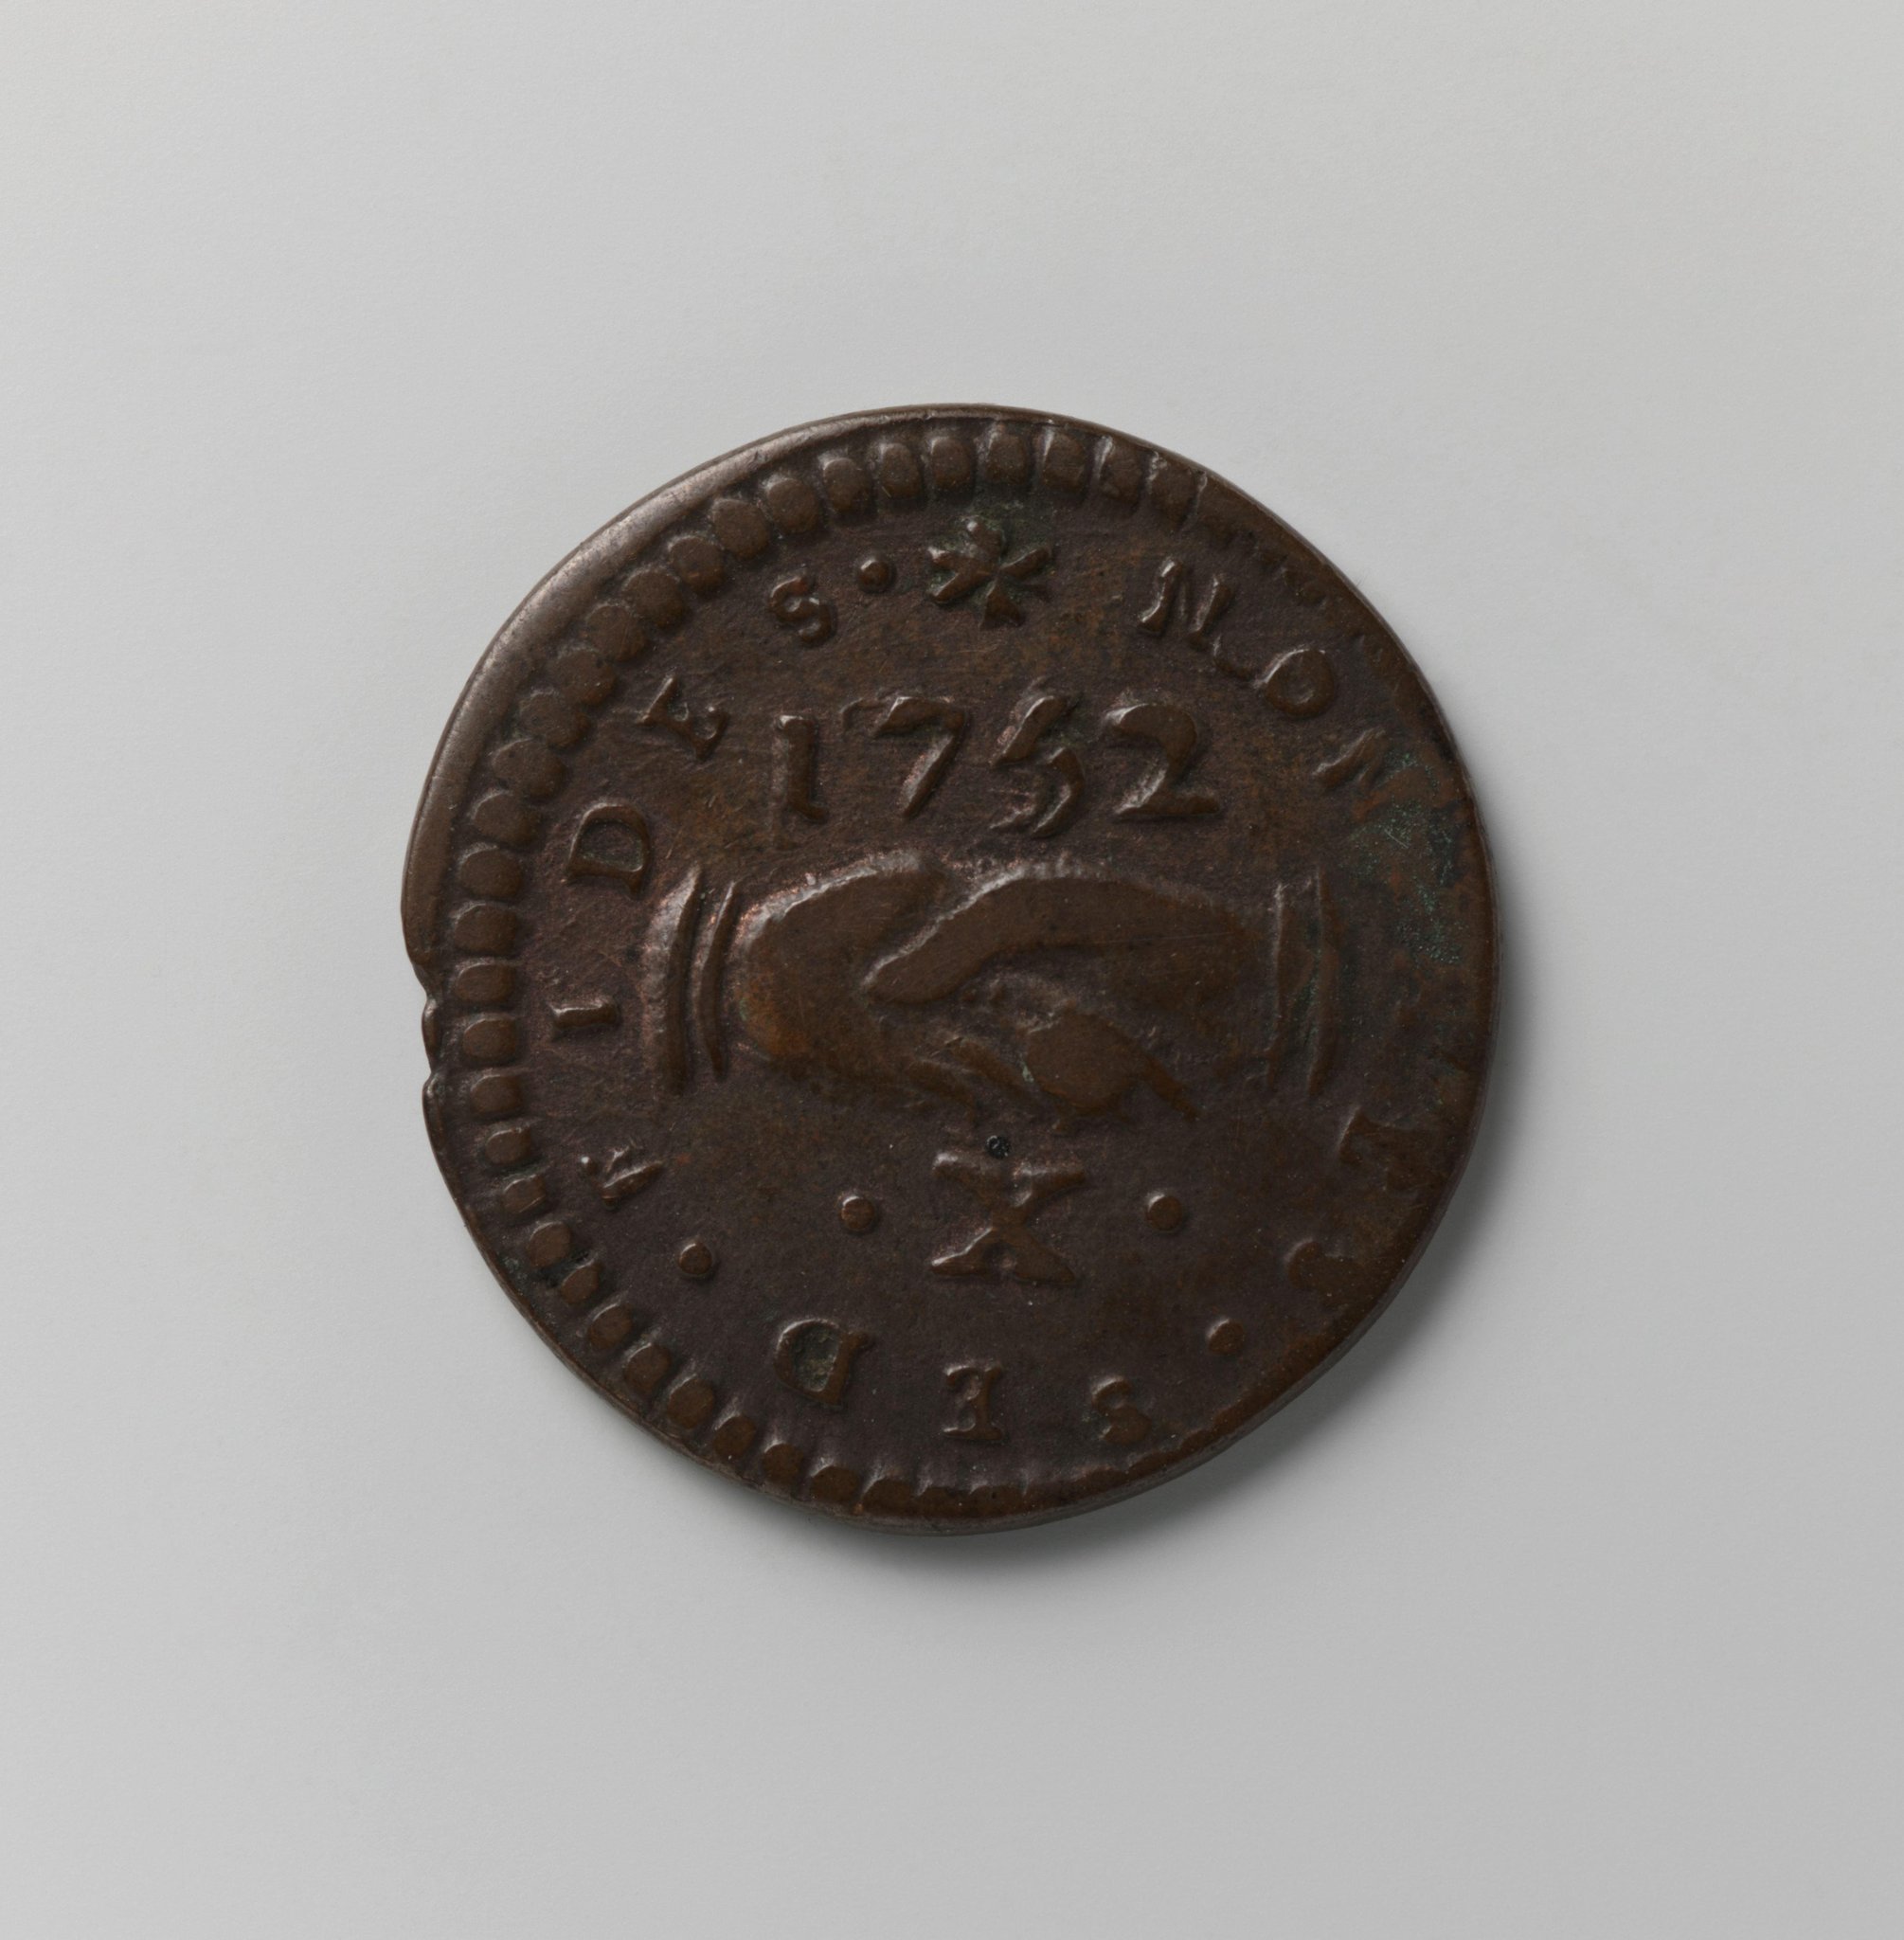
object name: coin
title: Malta, grootmeester Emanuele Pinto, carlino van 10 grani, 1752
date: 1752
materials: copper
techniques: striking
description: Koperen munt. Voorzijde: gekroond versierd wapenschild. Keerzijde: twee ineen geslagen handen, waarboven jaartal en waaronder waarde-aanduiding X [grani]. Gladde rand.